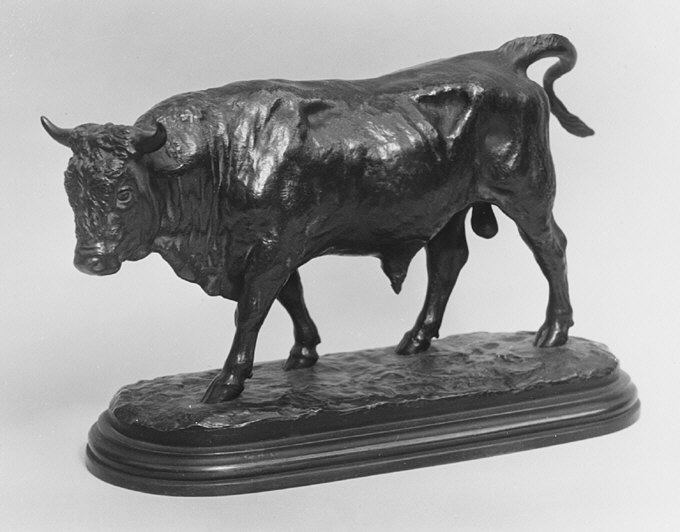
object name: statuette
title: Walking Bull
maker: rosa bonheur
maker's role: artist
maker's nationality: french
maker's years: 1822-1899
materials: bronze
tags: bulls